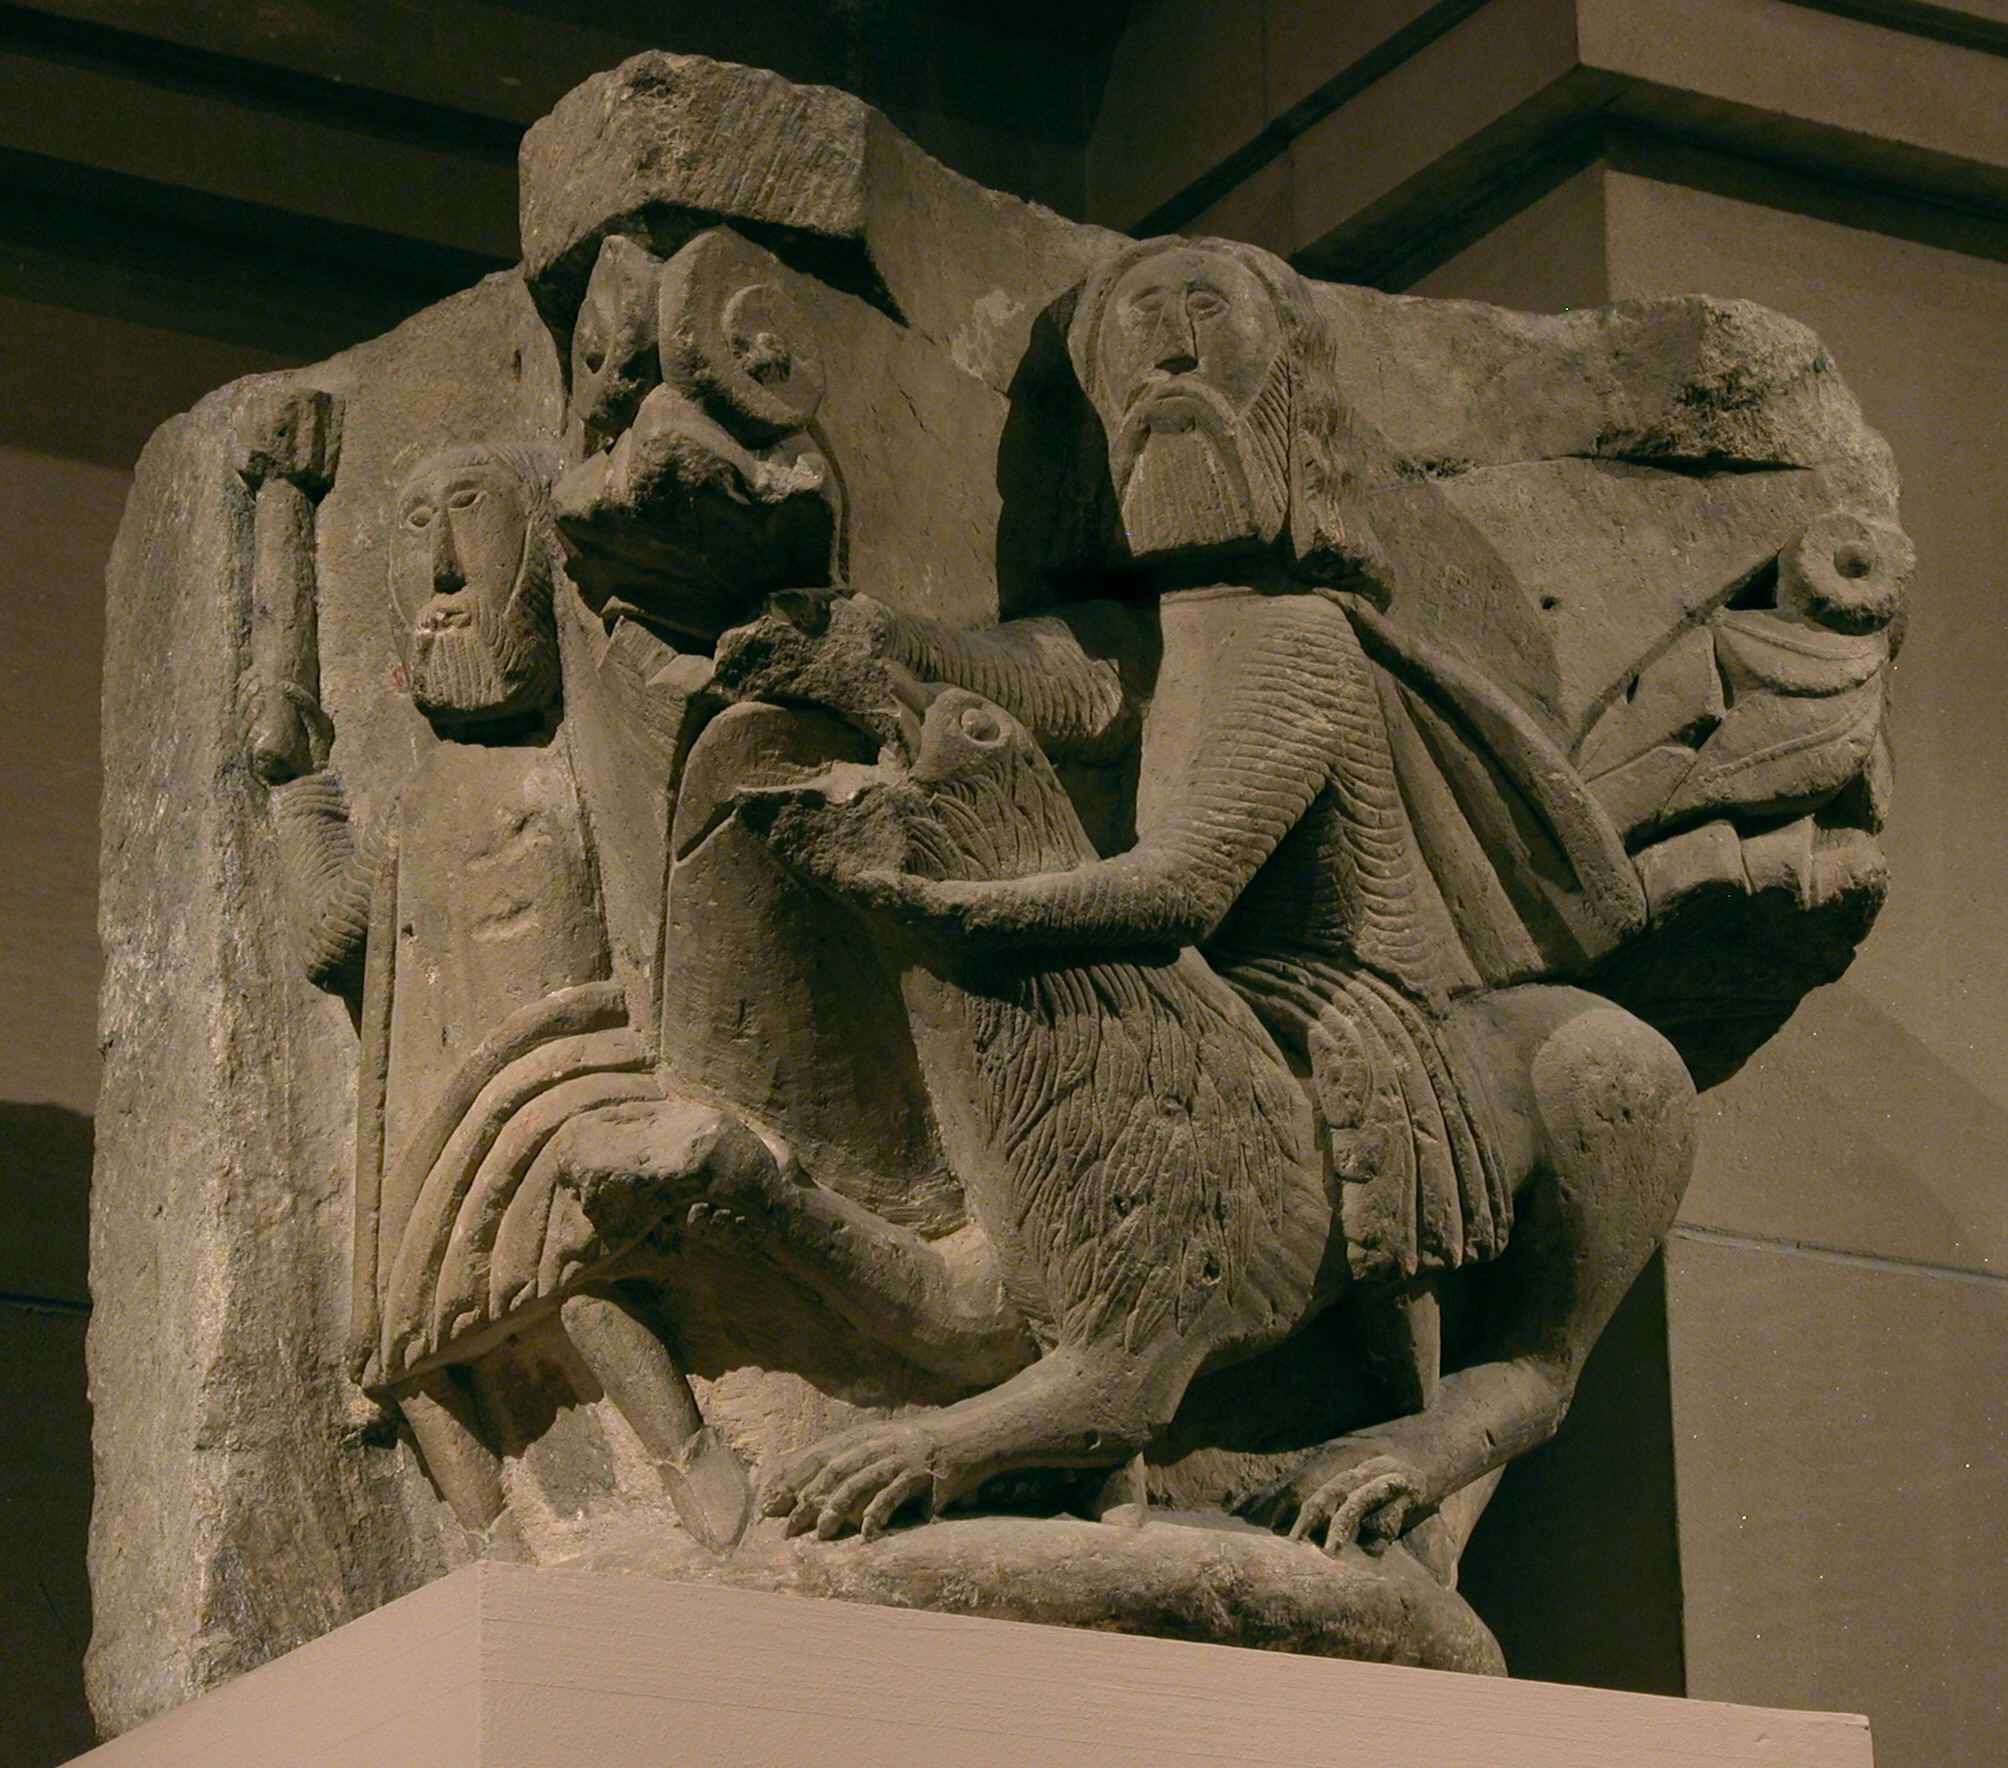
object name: capital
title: Capital with Samson and an Attendant Fighting a Lion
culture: spanish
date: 1175-1200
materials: limestone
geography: spain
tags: lions,samson